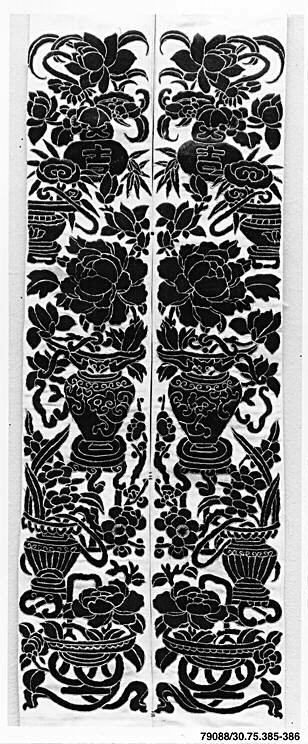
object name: sleeve band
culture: chinese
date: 1801-1900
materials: metal thread, silk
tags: flowers